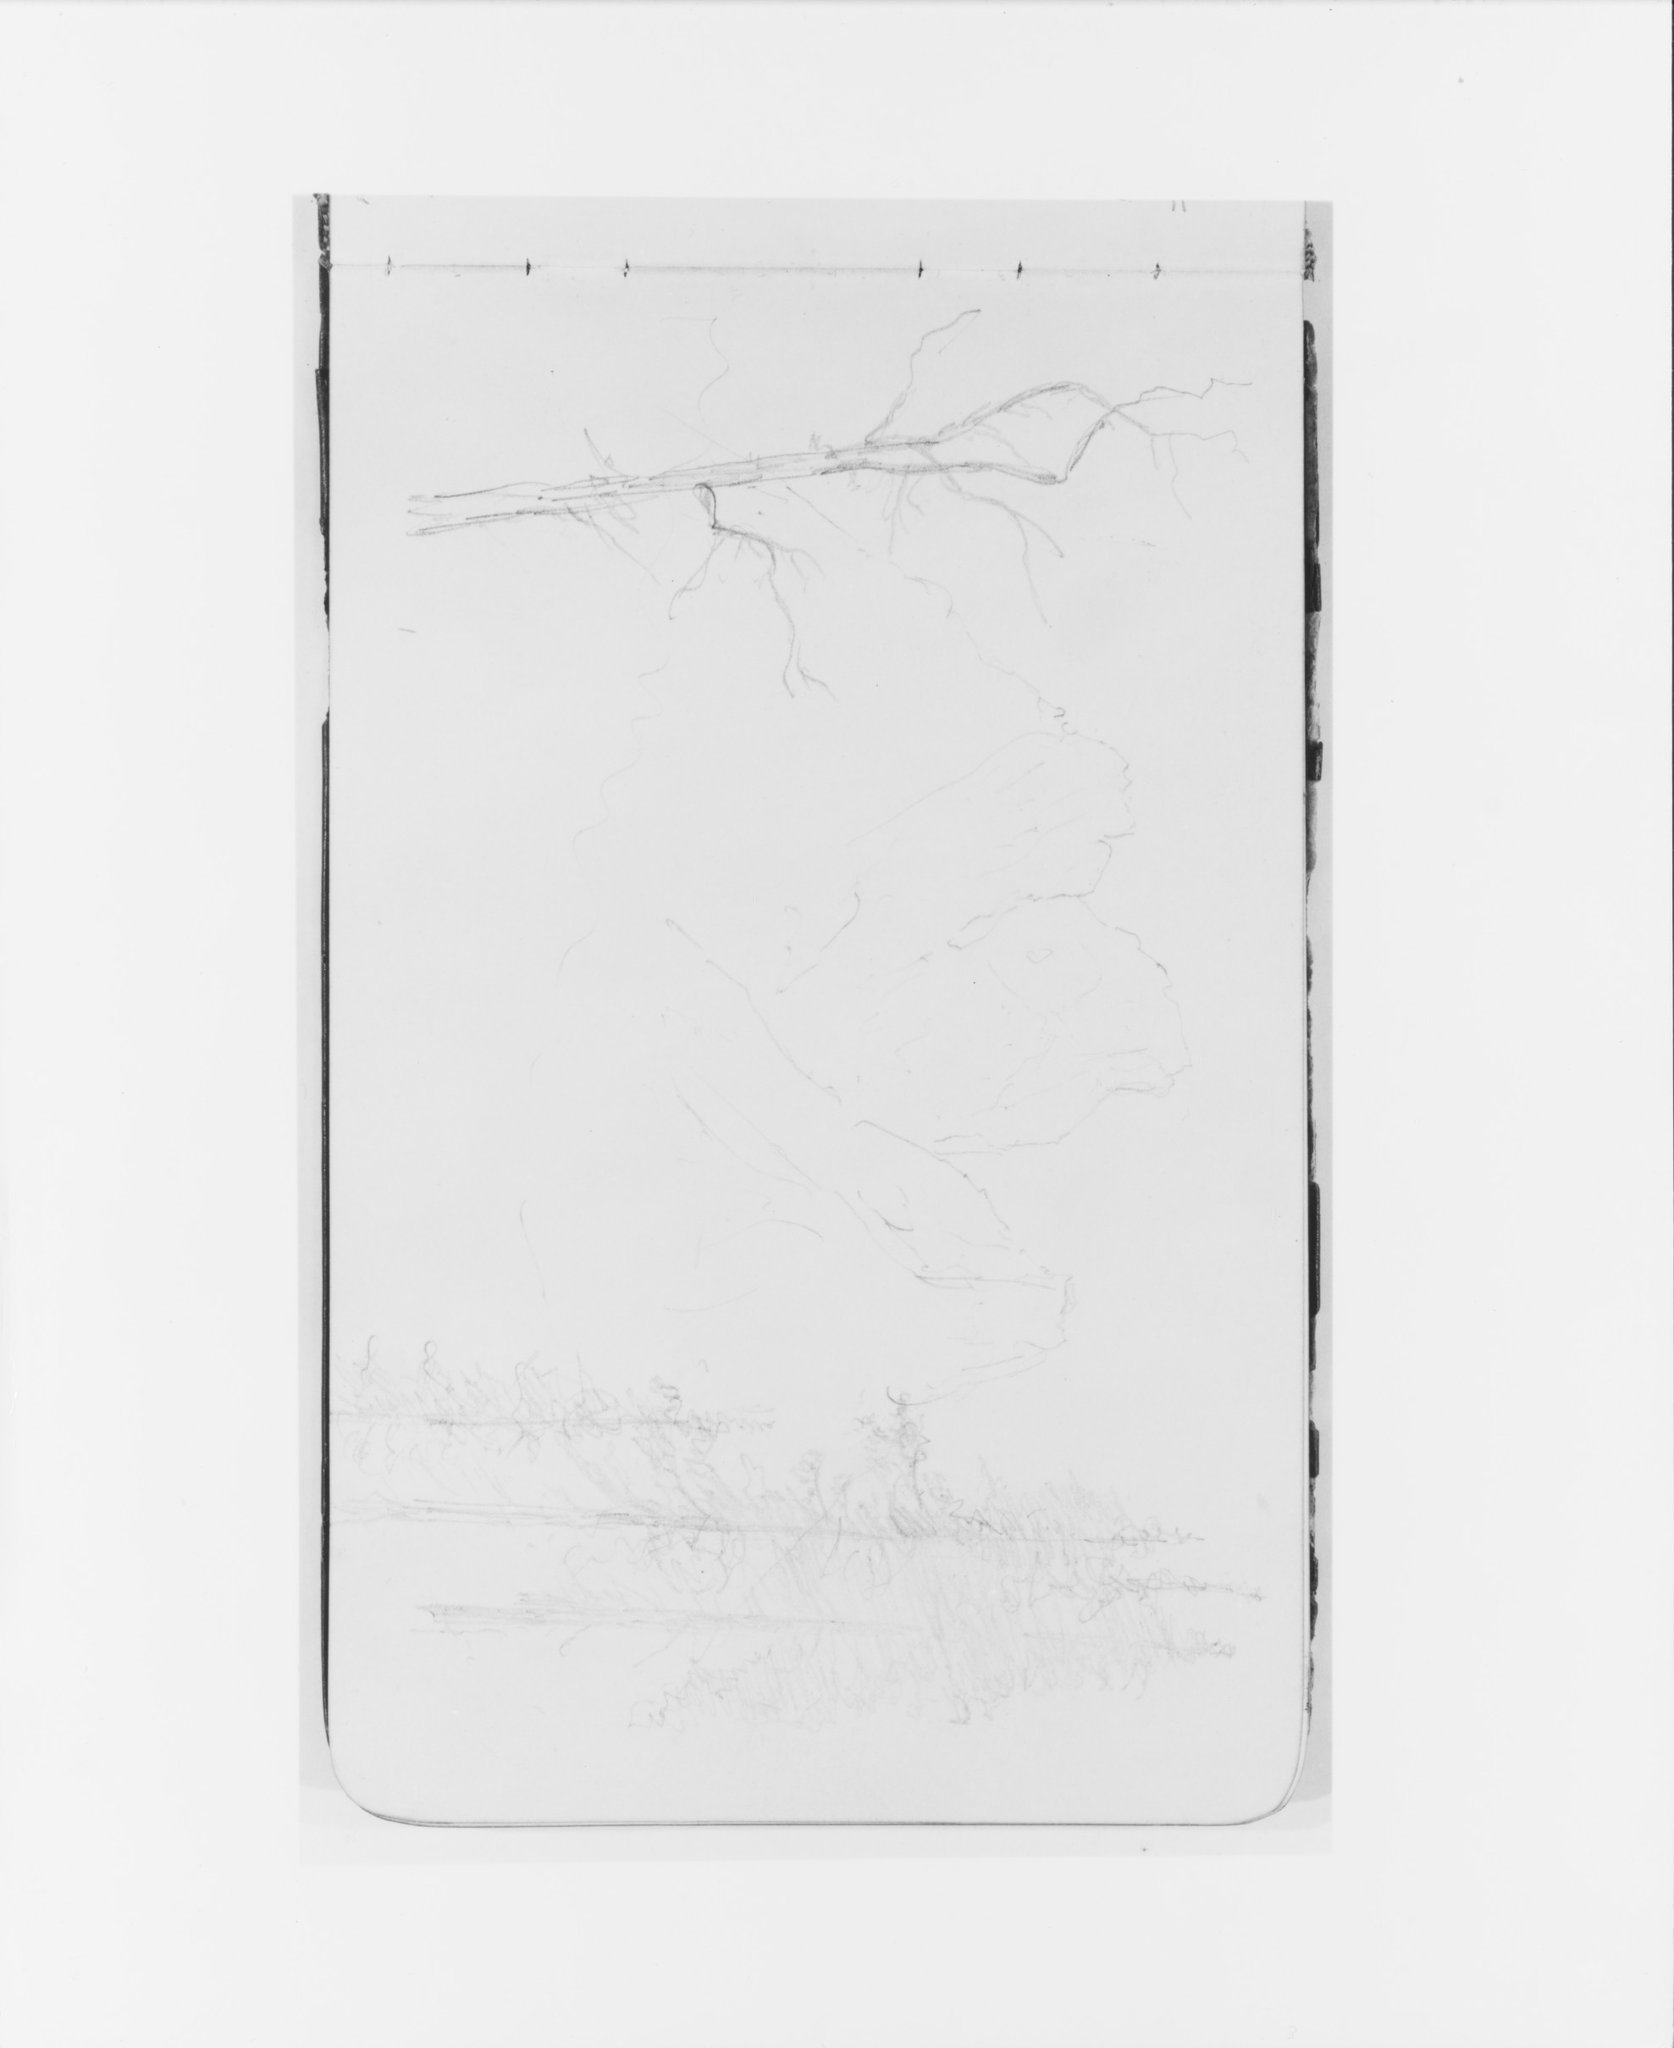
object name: drawing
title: Canadian Landscape with Mountains and Trees (from Sketchbook)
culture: american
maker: albert bierstadt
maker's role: artist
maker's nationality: american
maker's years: 1830-1902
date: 1890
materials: graphite, paper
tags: mountains,trees